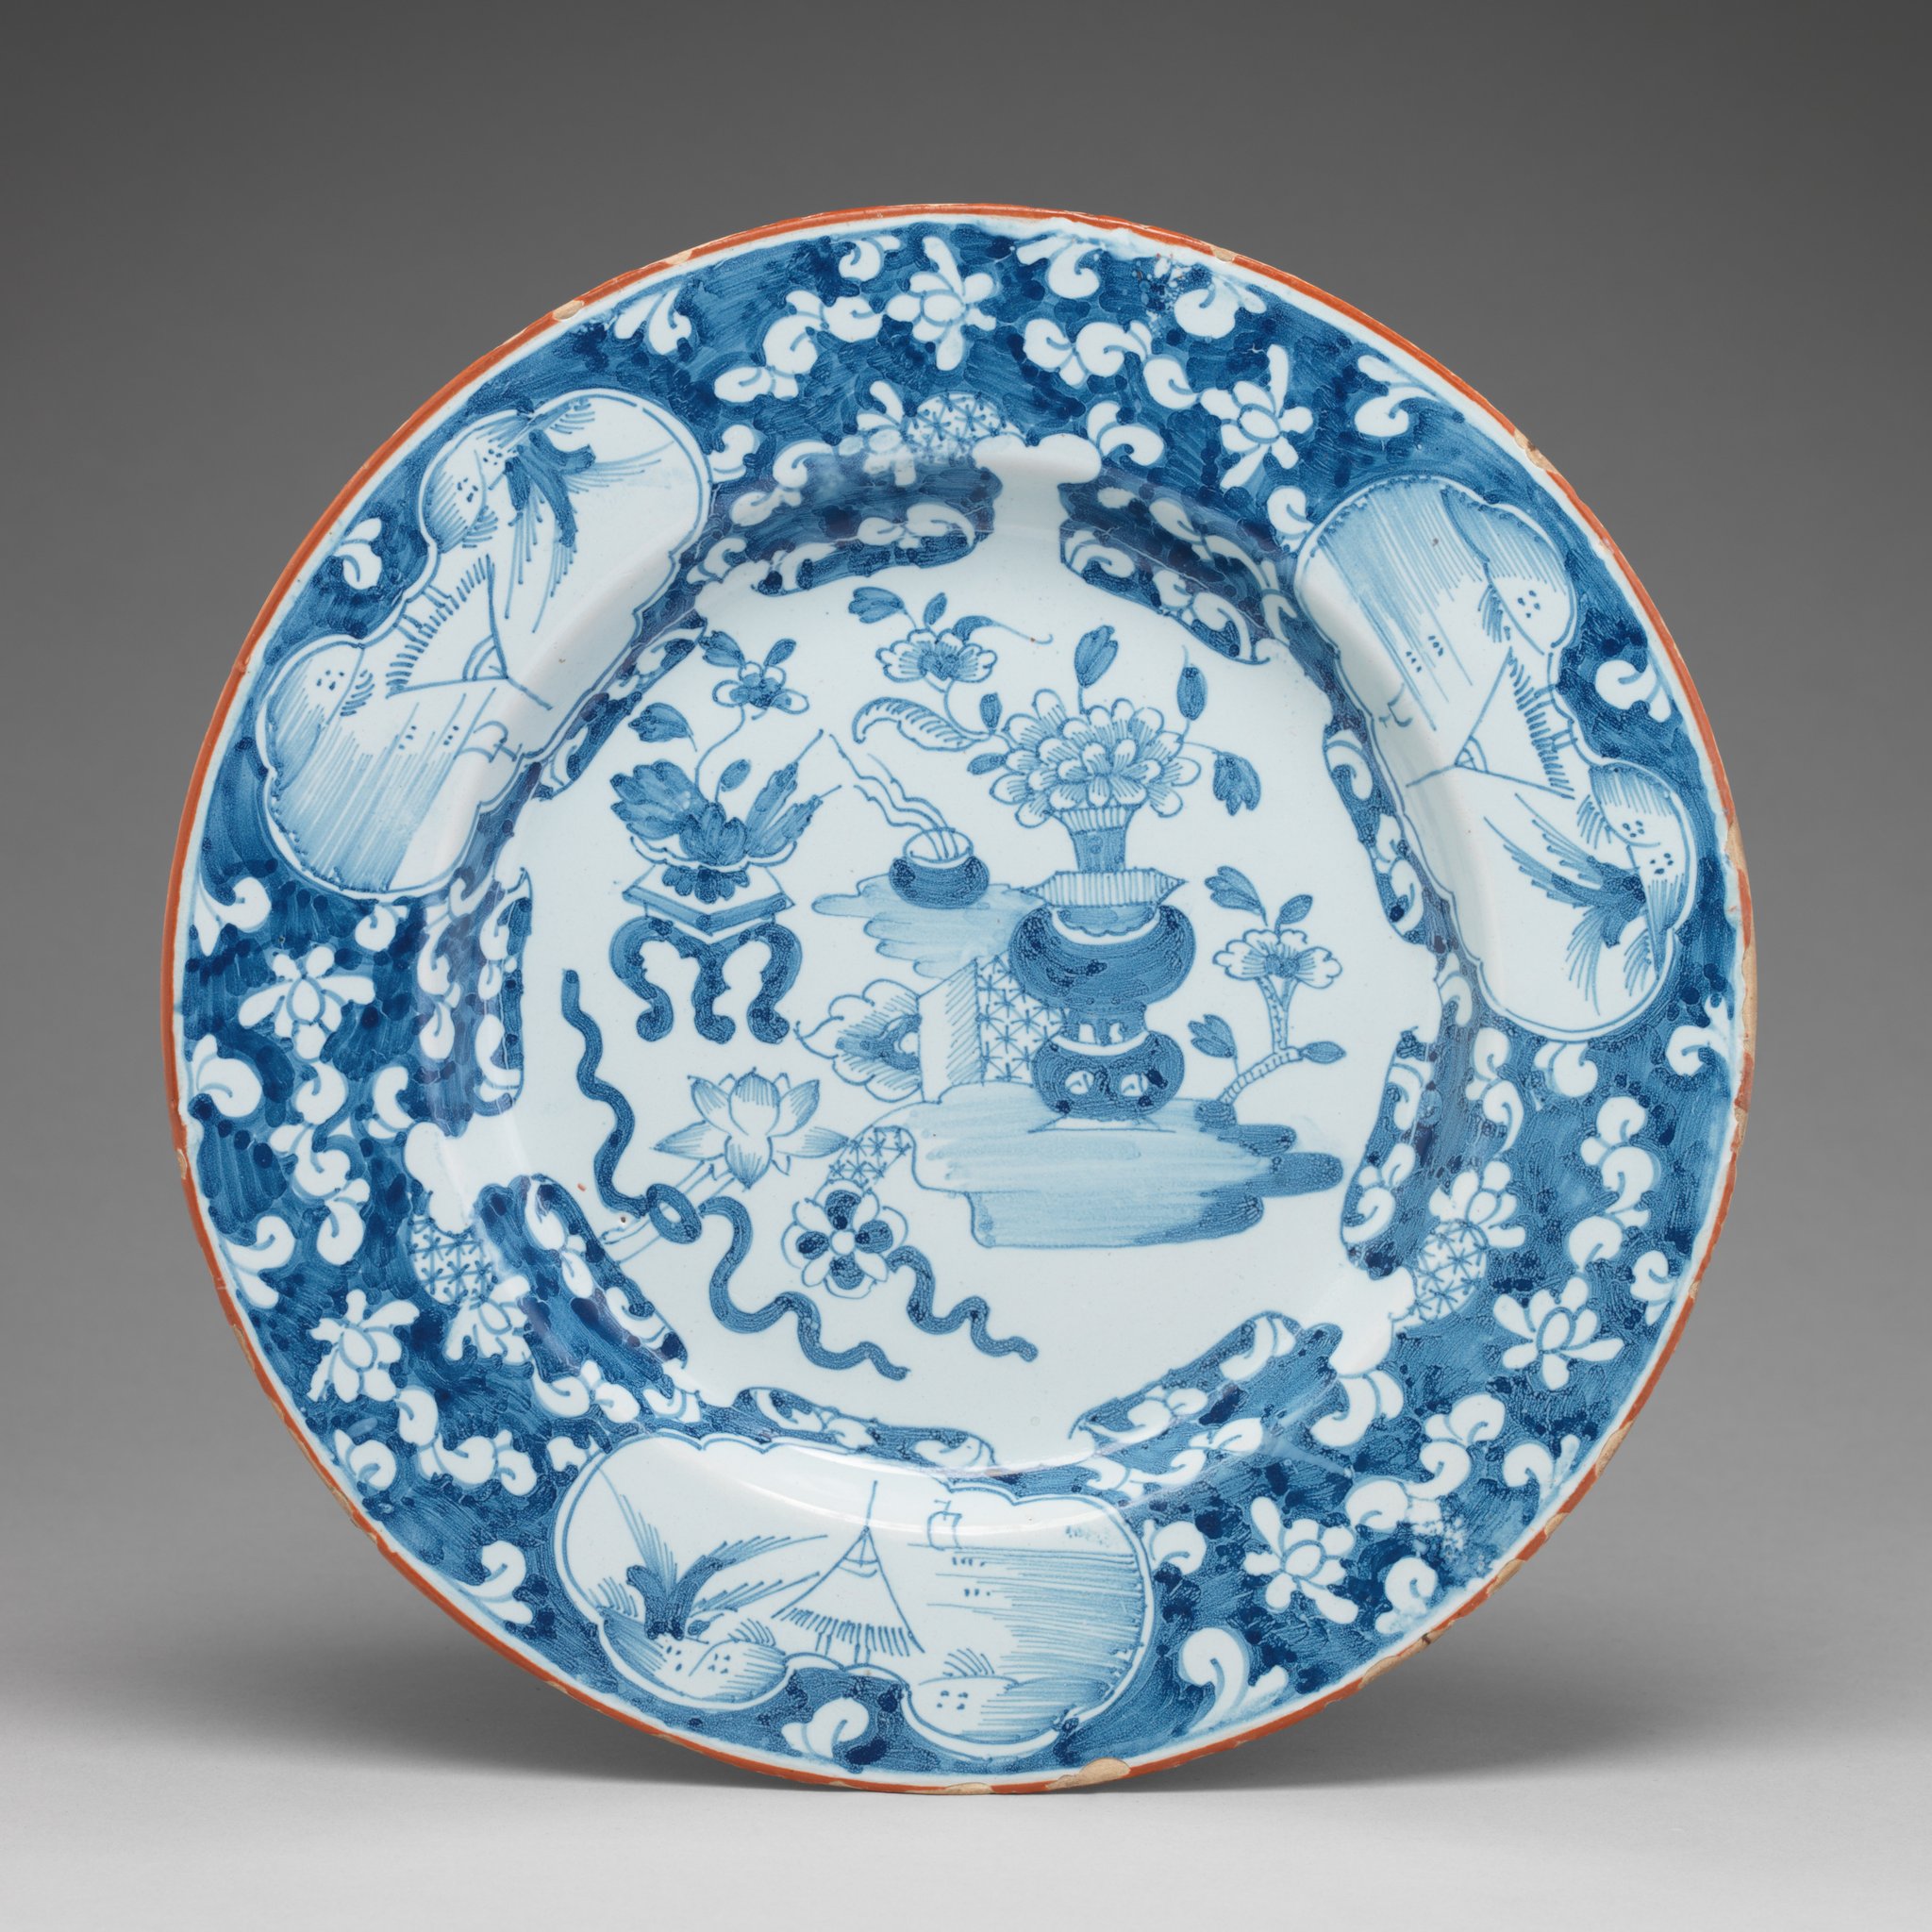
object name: plate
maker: joseph flower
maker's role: factory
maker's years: 1700-1800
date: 1750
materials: earthenware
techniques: glazing